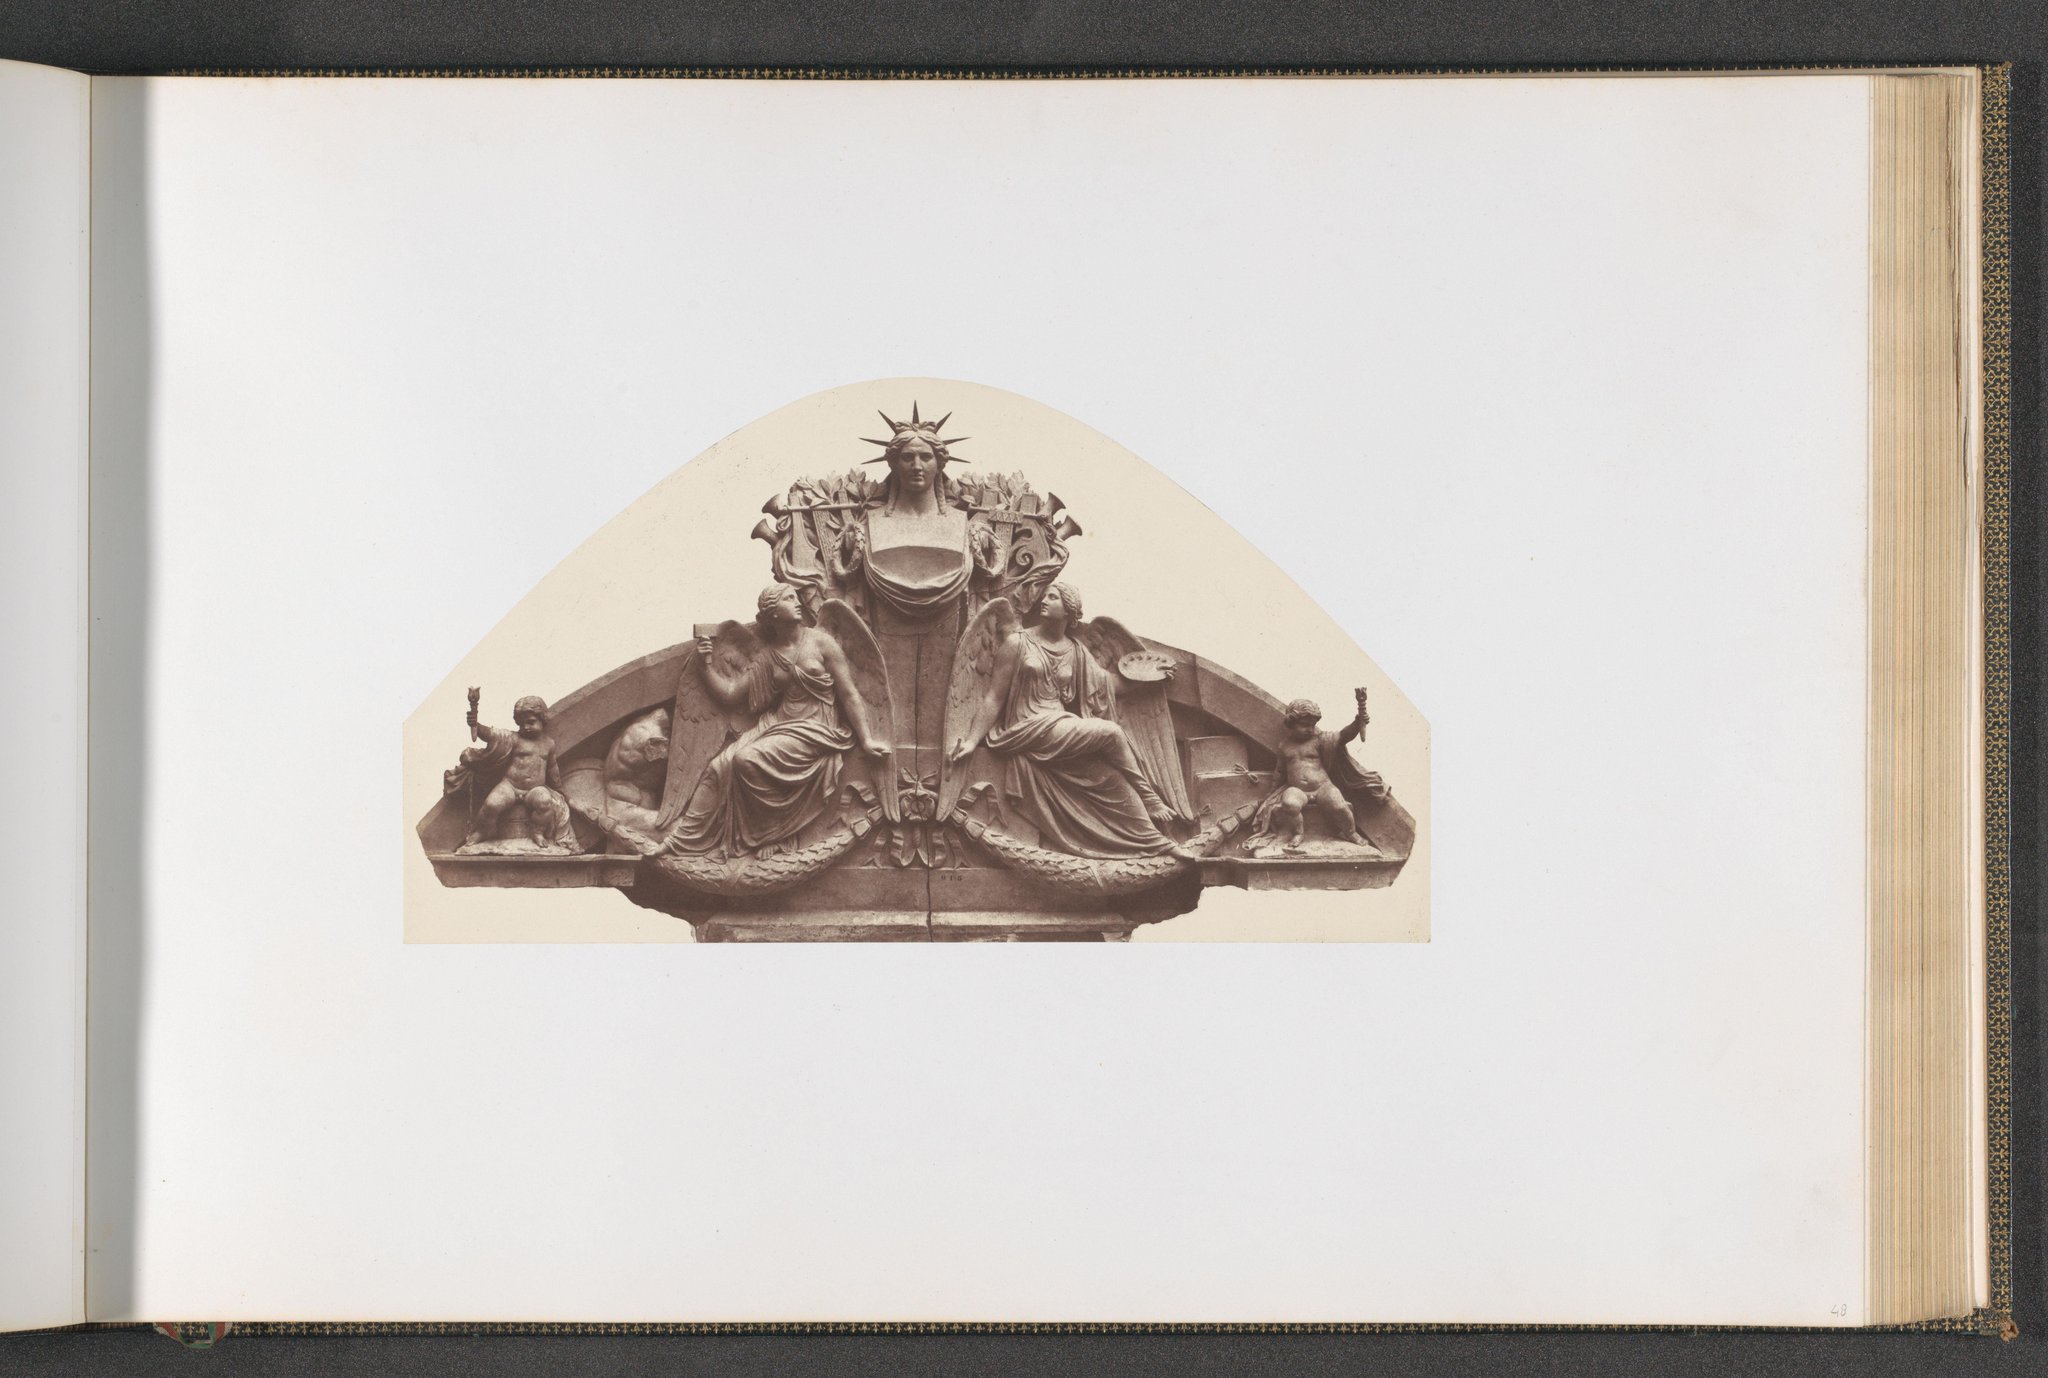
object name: album leaf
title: Gipsmodel voor beeldhouwwerk op het Palais du Louvre: "La Sculpture et la Peinture" door François Félix Roubaud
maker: édouard denis baldus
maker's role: fotograaf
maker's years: 1813-1889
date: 1855-1857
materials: paper, photographic support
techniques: salted paper print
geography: paris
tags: piece of sculpture, reproduction of a piece of sculpture, permanent exhibition, museum, paris, tuileries palace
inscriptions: number: ‘918’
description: Onderdeel van Réunion des Tuileries au Louvre 1852-1857, album 2.